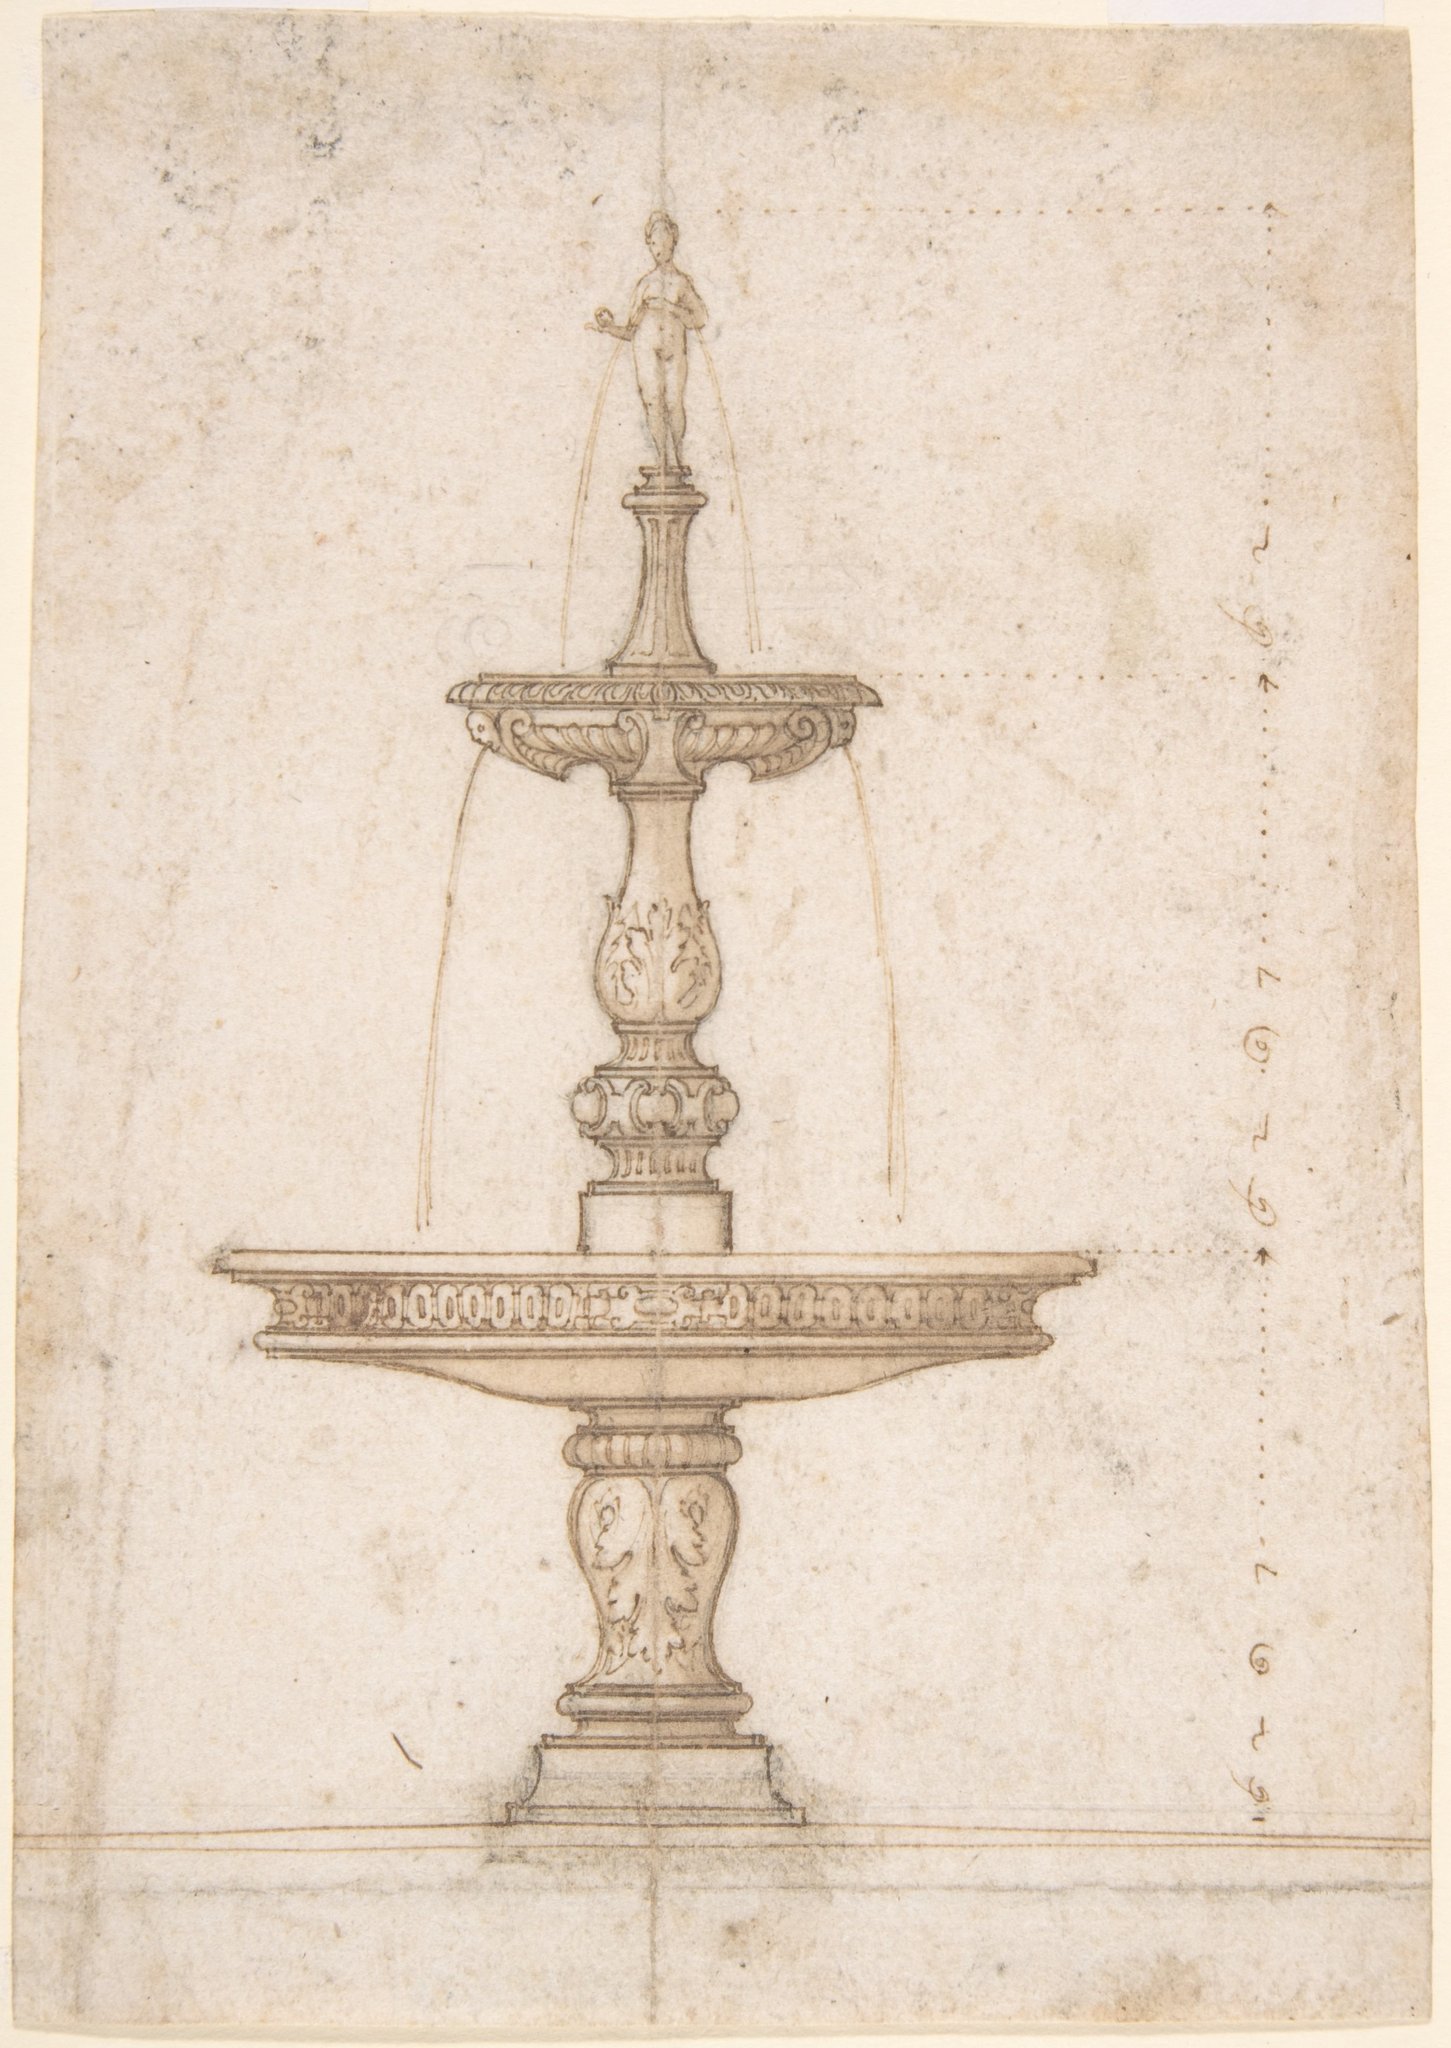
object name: collection ornament architecture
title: Design for a Table Fountain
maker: anonymous, german, 16th century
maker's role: artist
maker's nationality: german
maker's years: 1500-1600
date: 1501-1600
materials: chalk, ink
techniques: pen, wash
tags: fountains